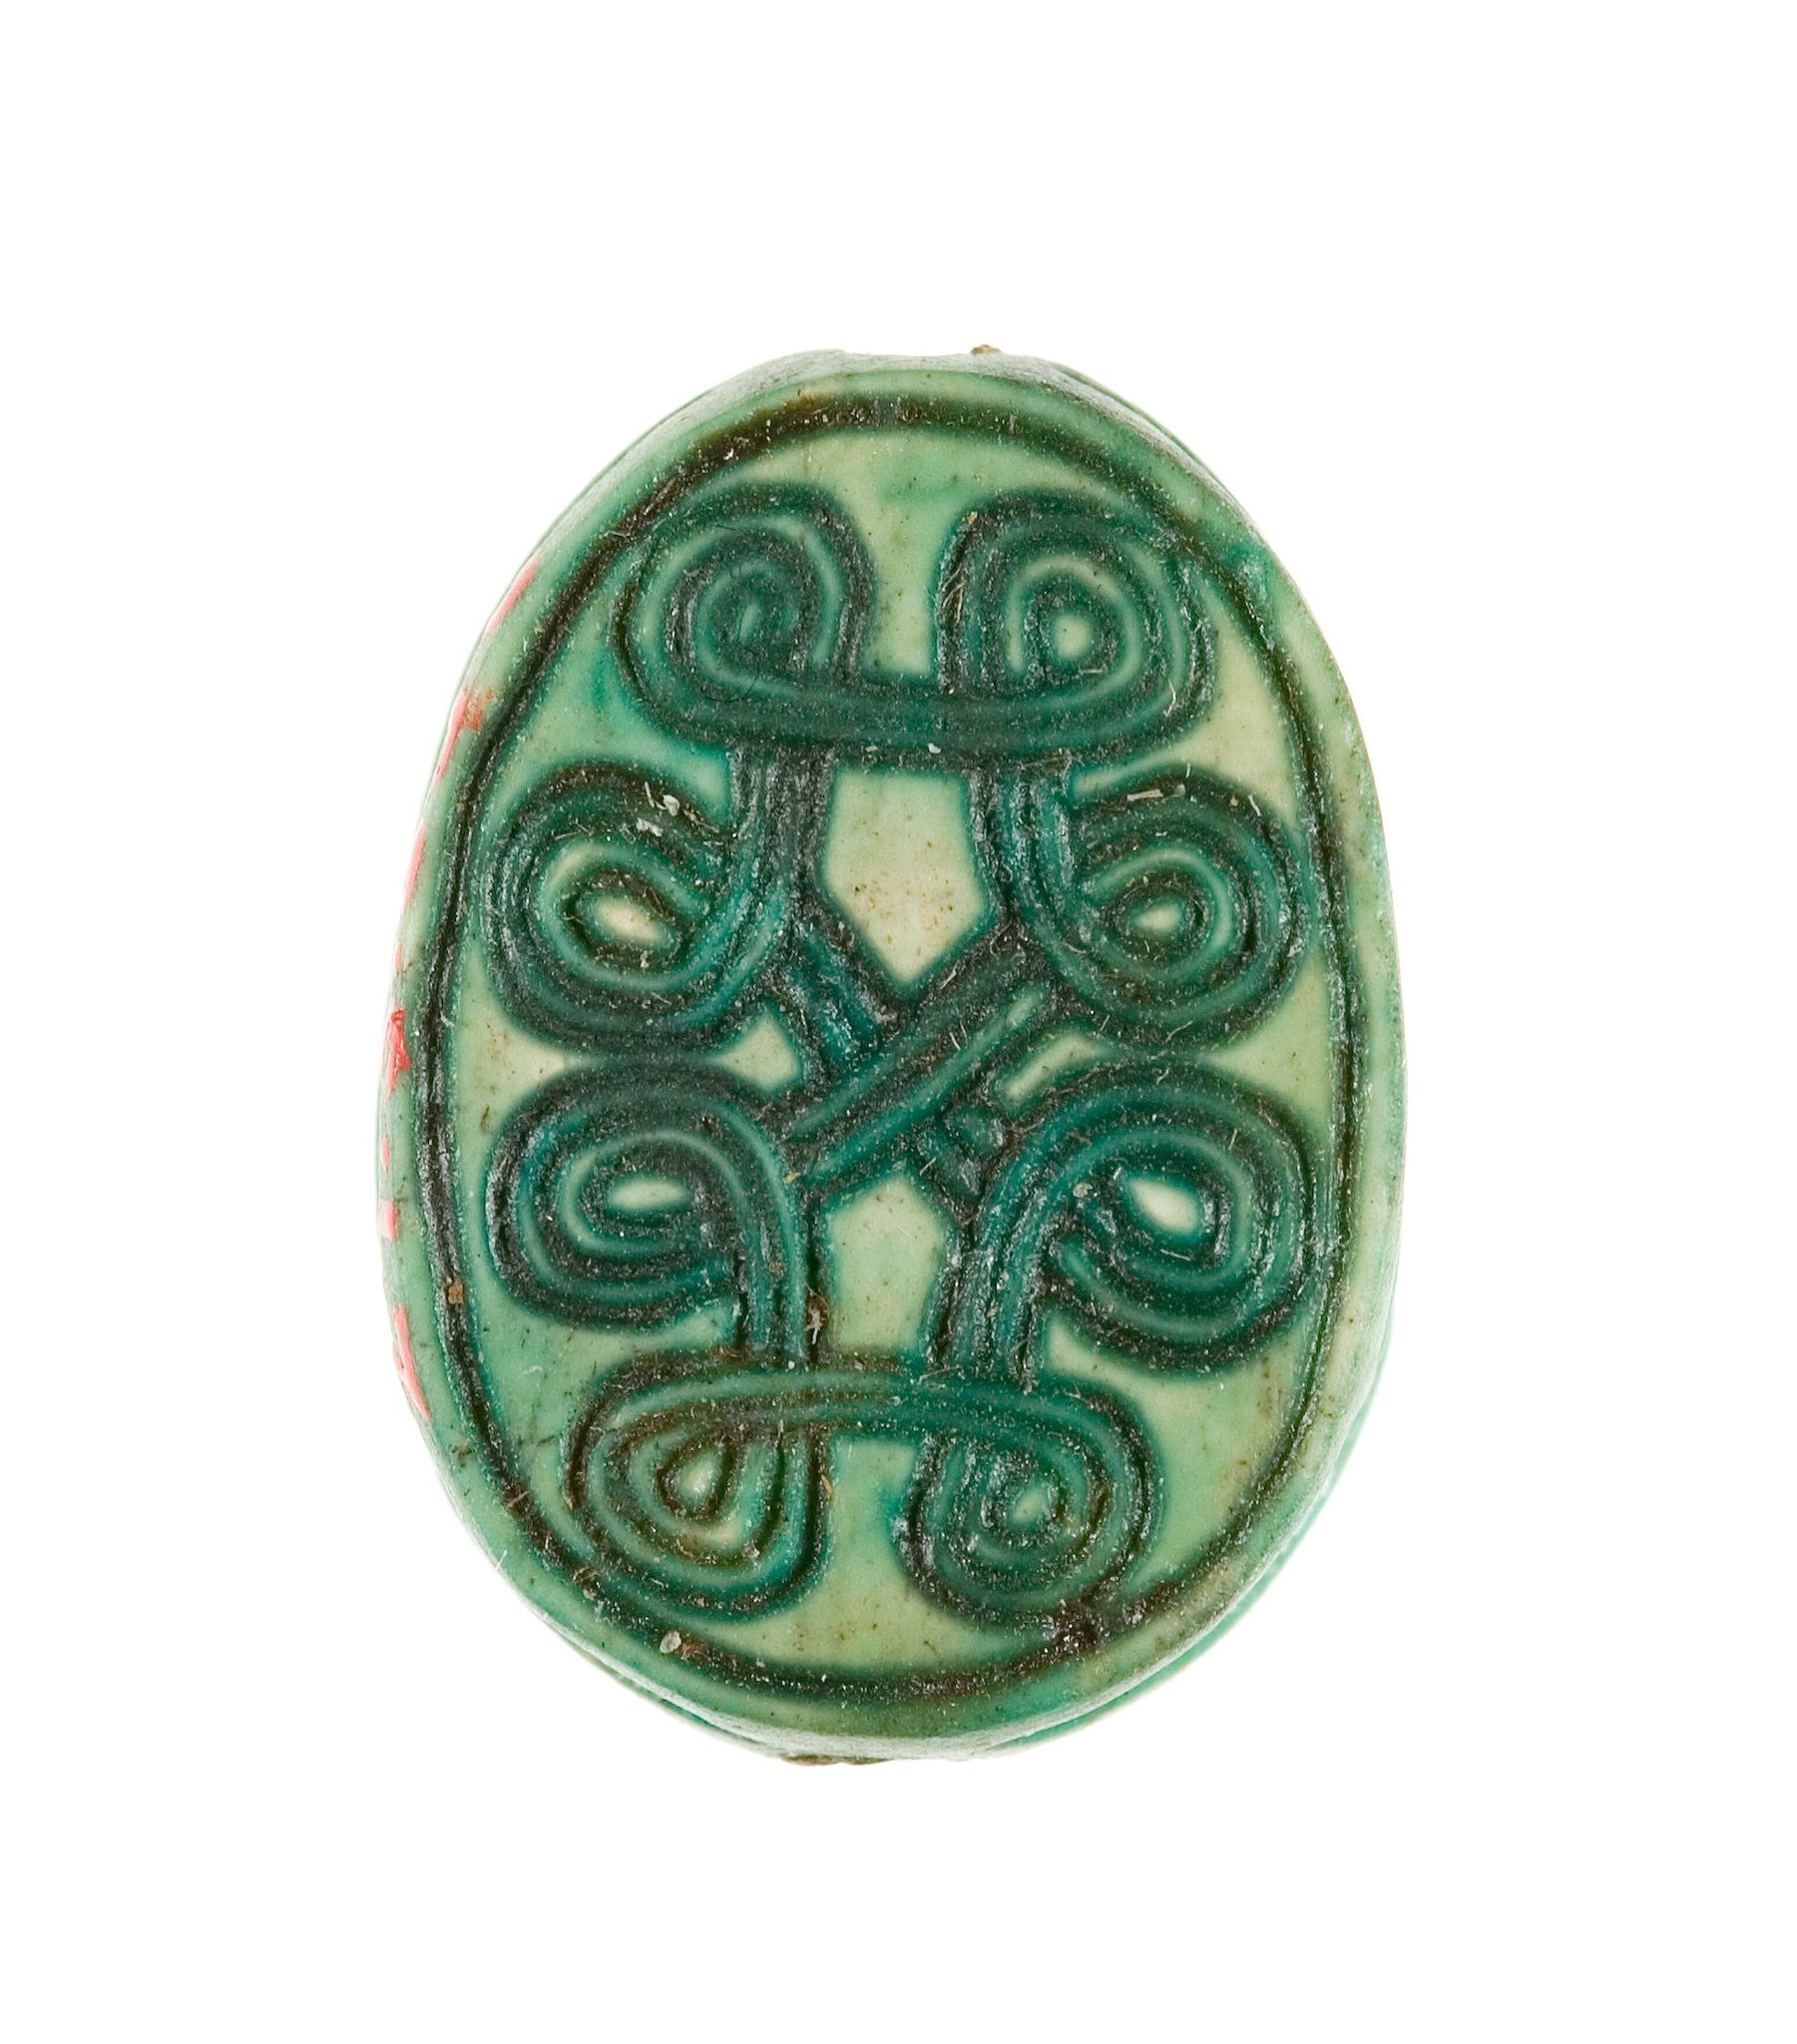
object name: scarab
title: Scarab Inscribed with a Geometric Pattern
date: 1479-1458 BCE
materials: stone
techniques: glazing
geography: egypt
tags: scarabs